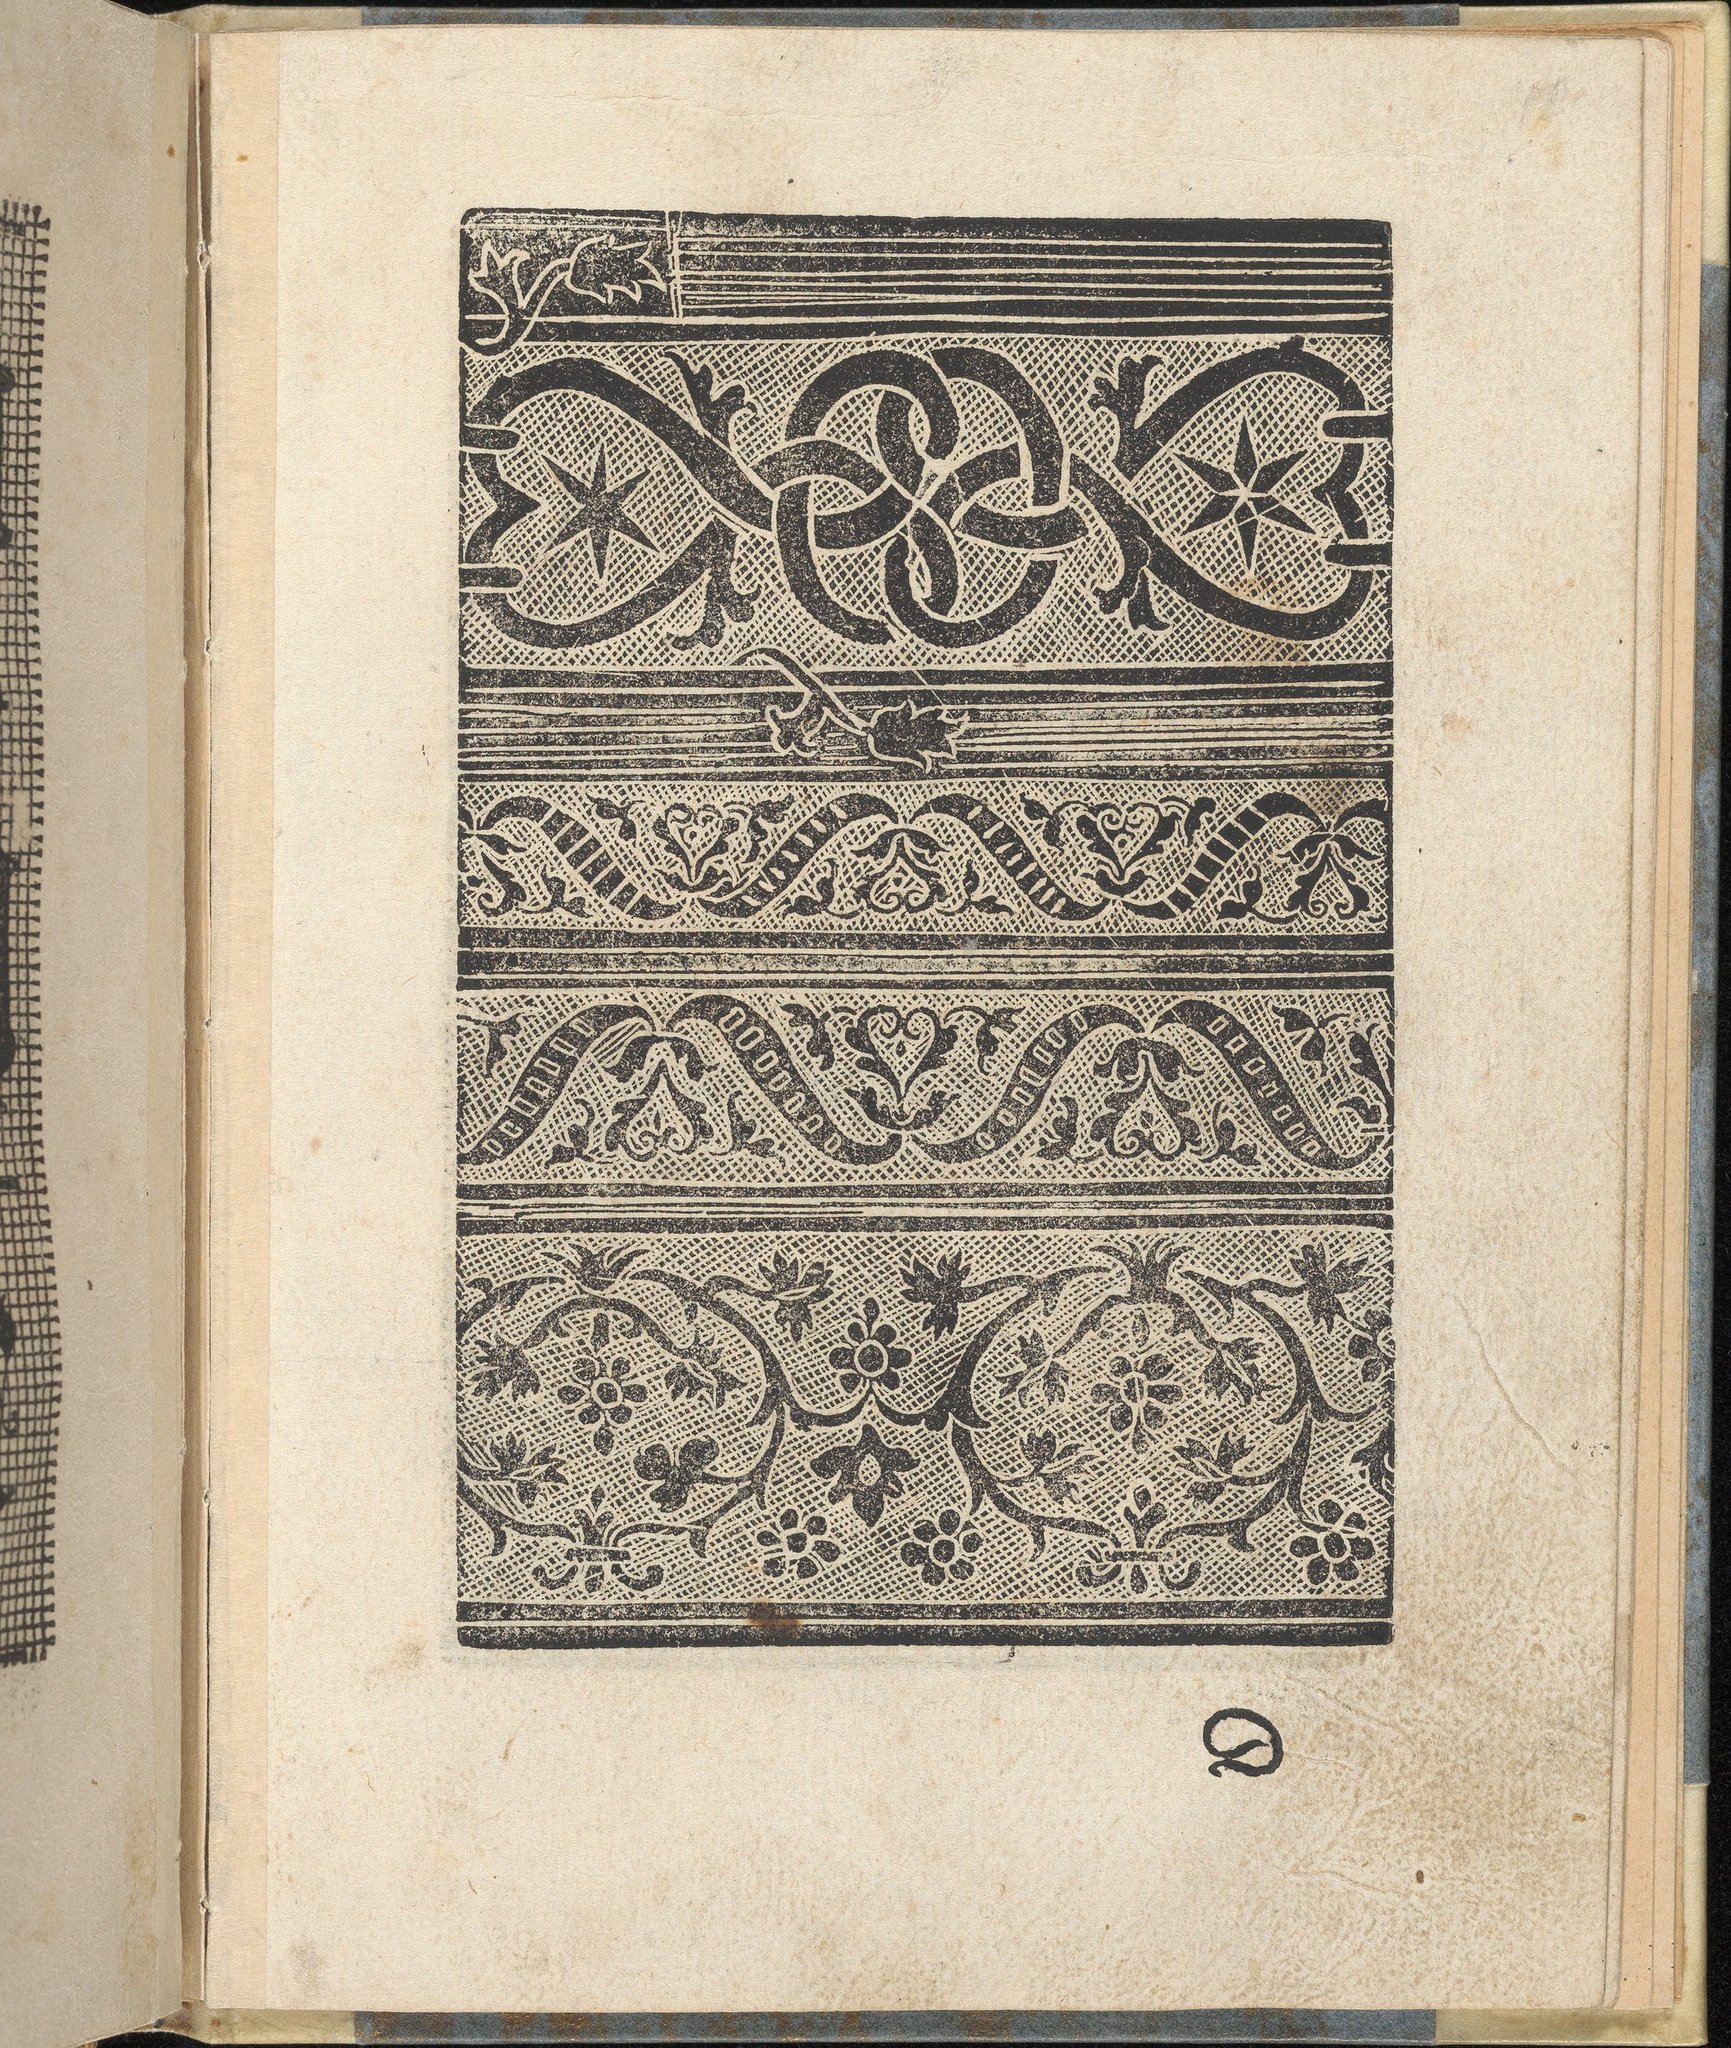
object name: book print ornament architecture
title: Ein ney Furmbüchlein, Page 11, recto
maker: johann schönsperger the younger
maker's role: publisher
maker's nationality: german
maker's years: 1490-1550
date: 1525-1529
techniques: woodcut